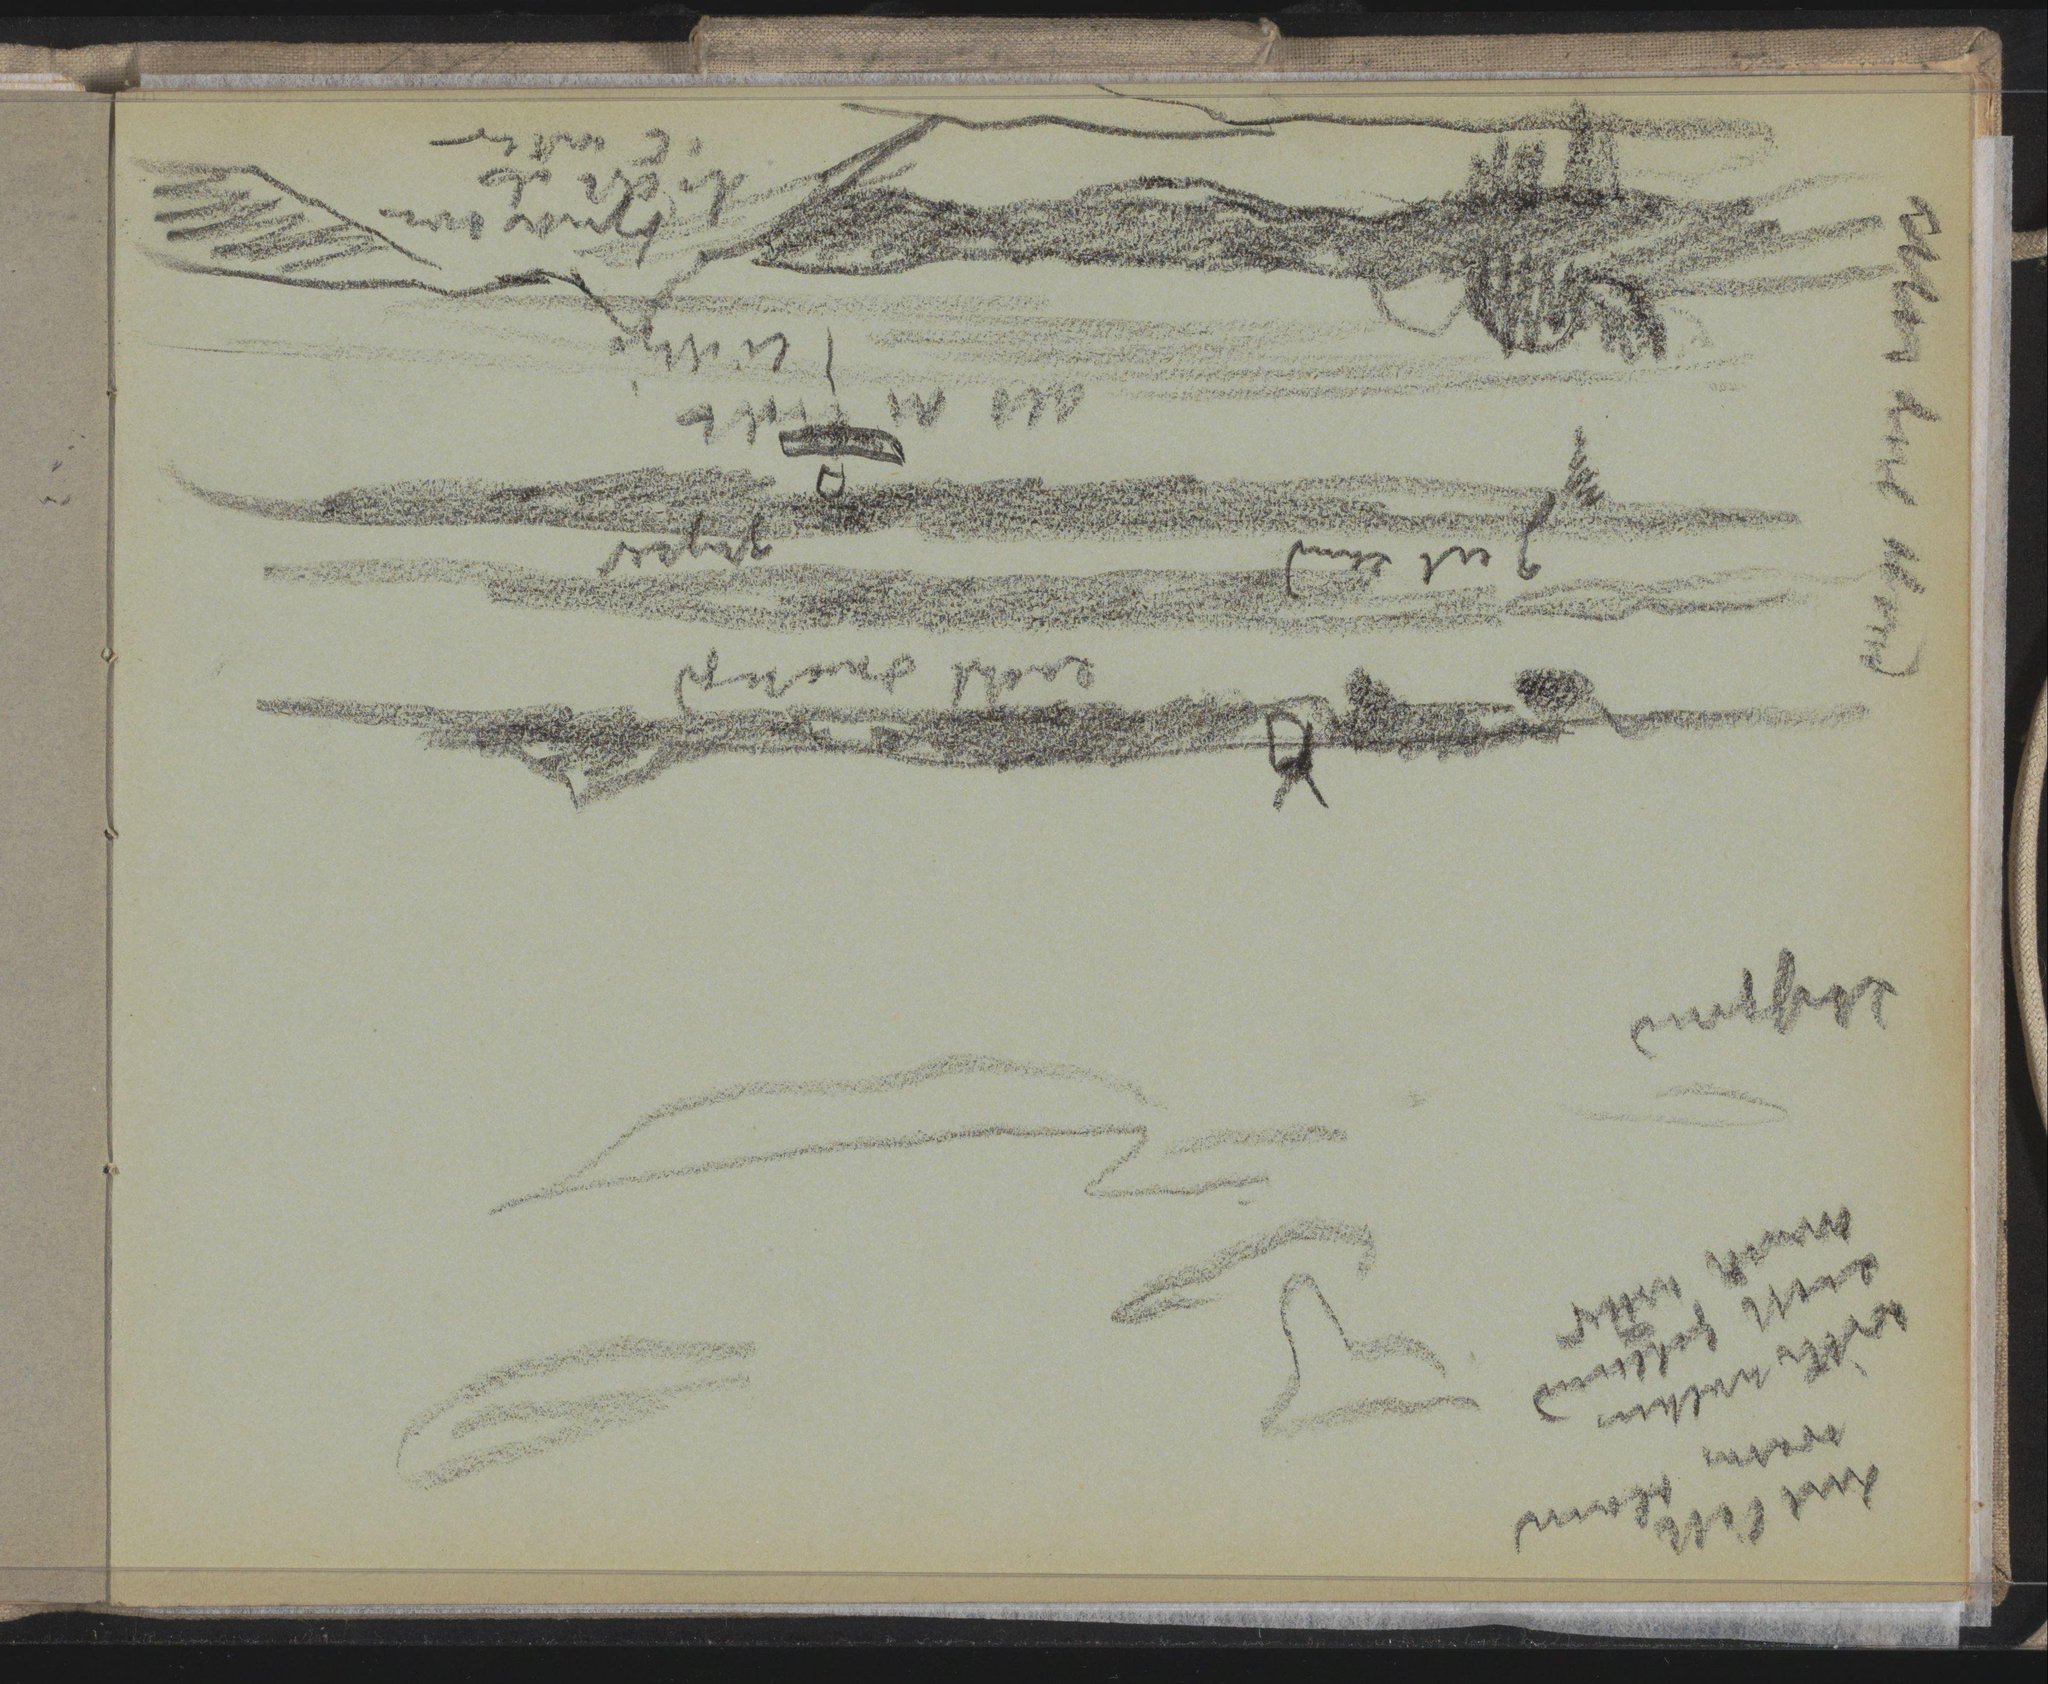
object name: sketchbook leaf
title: Rivierlandschap met een molen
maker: willem witsen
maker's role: draughtsman, painter, print maker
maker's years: 1860-1923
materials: chalk, paper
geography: wijk bij duurstede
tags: river, windmill in landscape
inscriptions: kleurnotitie, handgeschreven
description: Pagina 35 uit een schetsboek met 43 bladen.